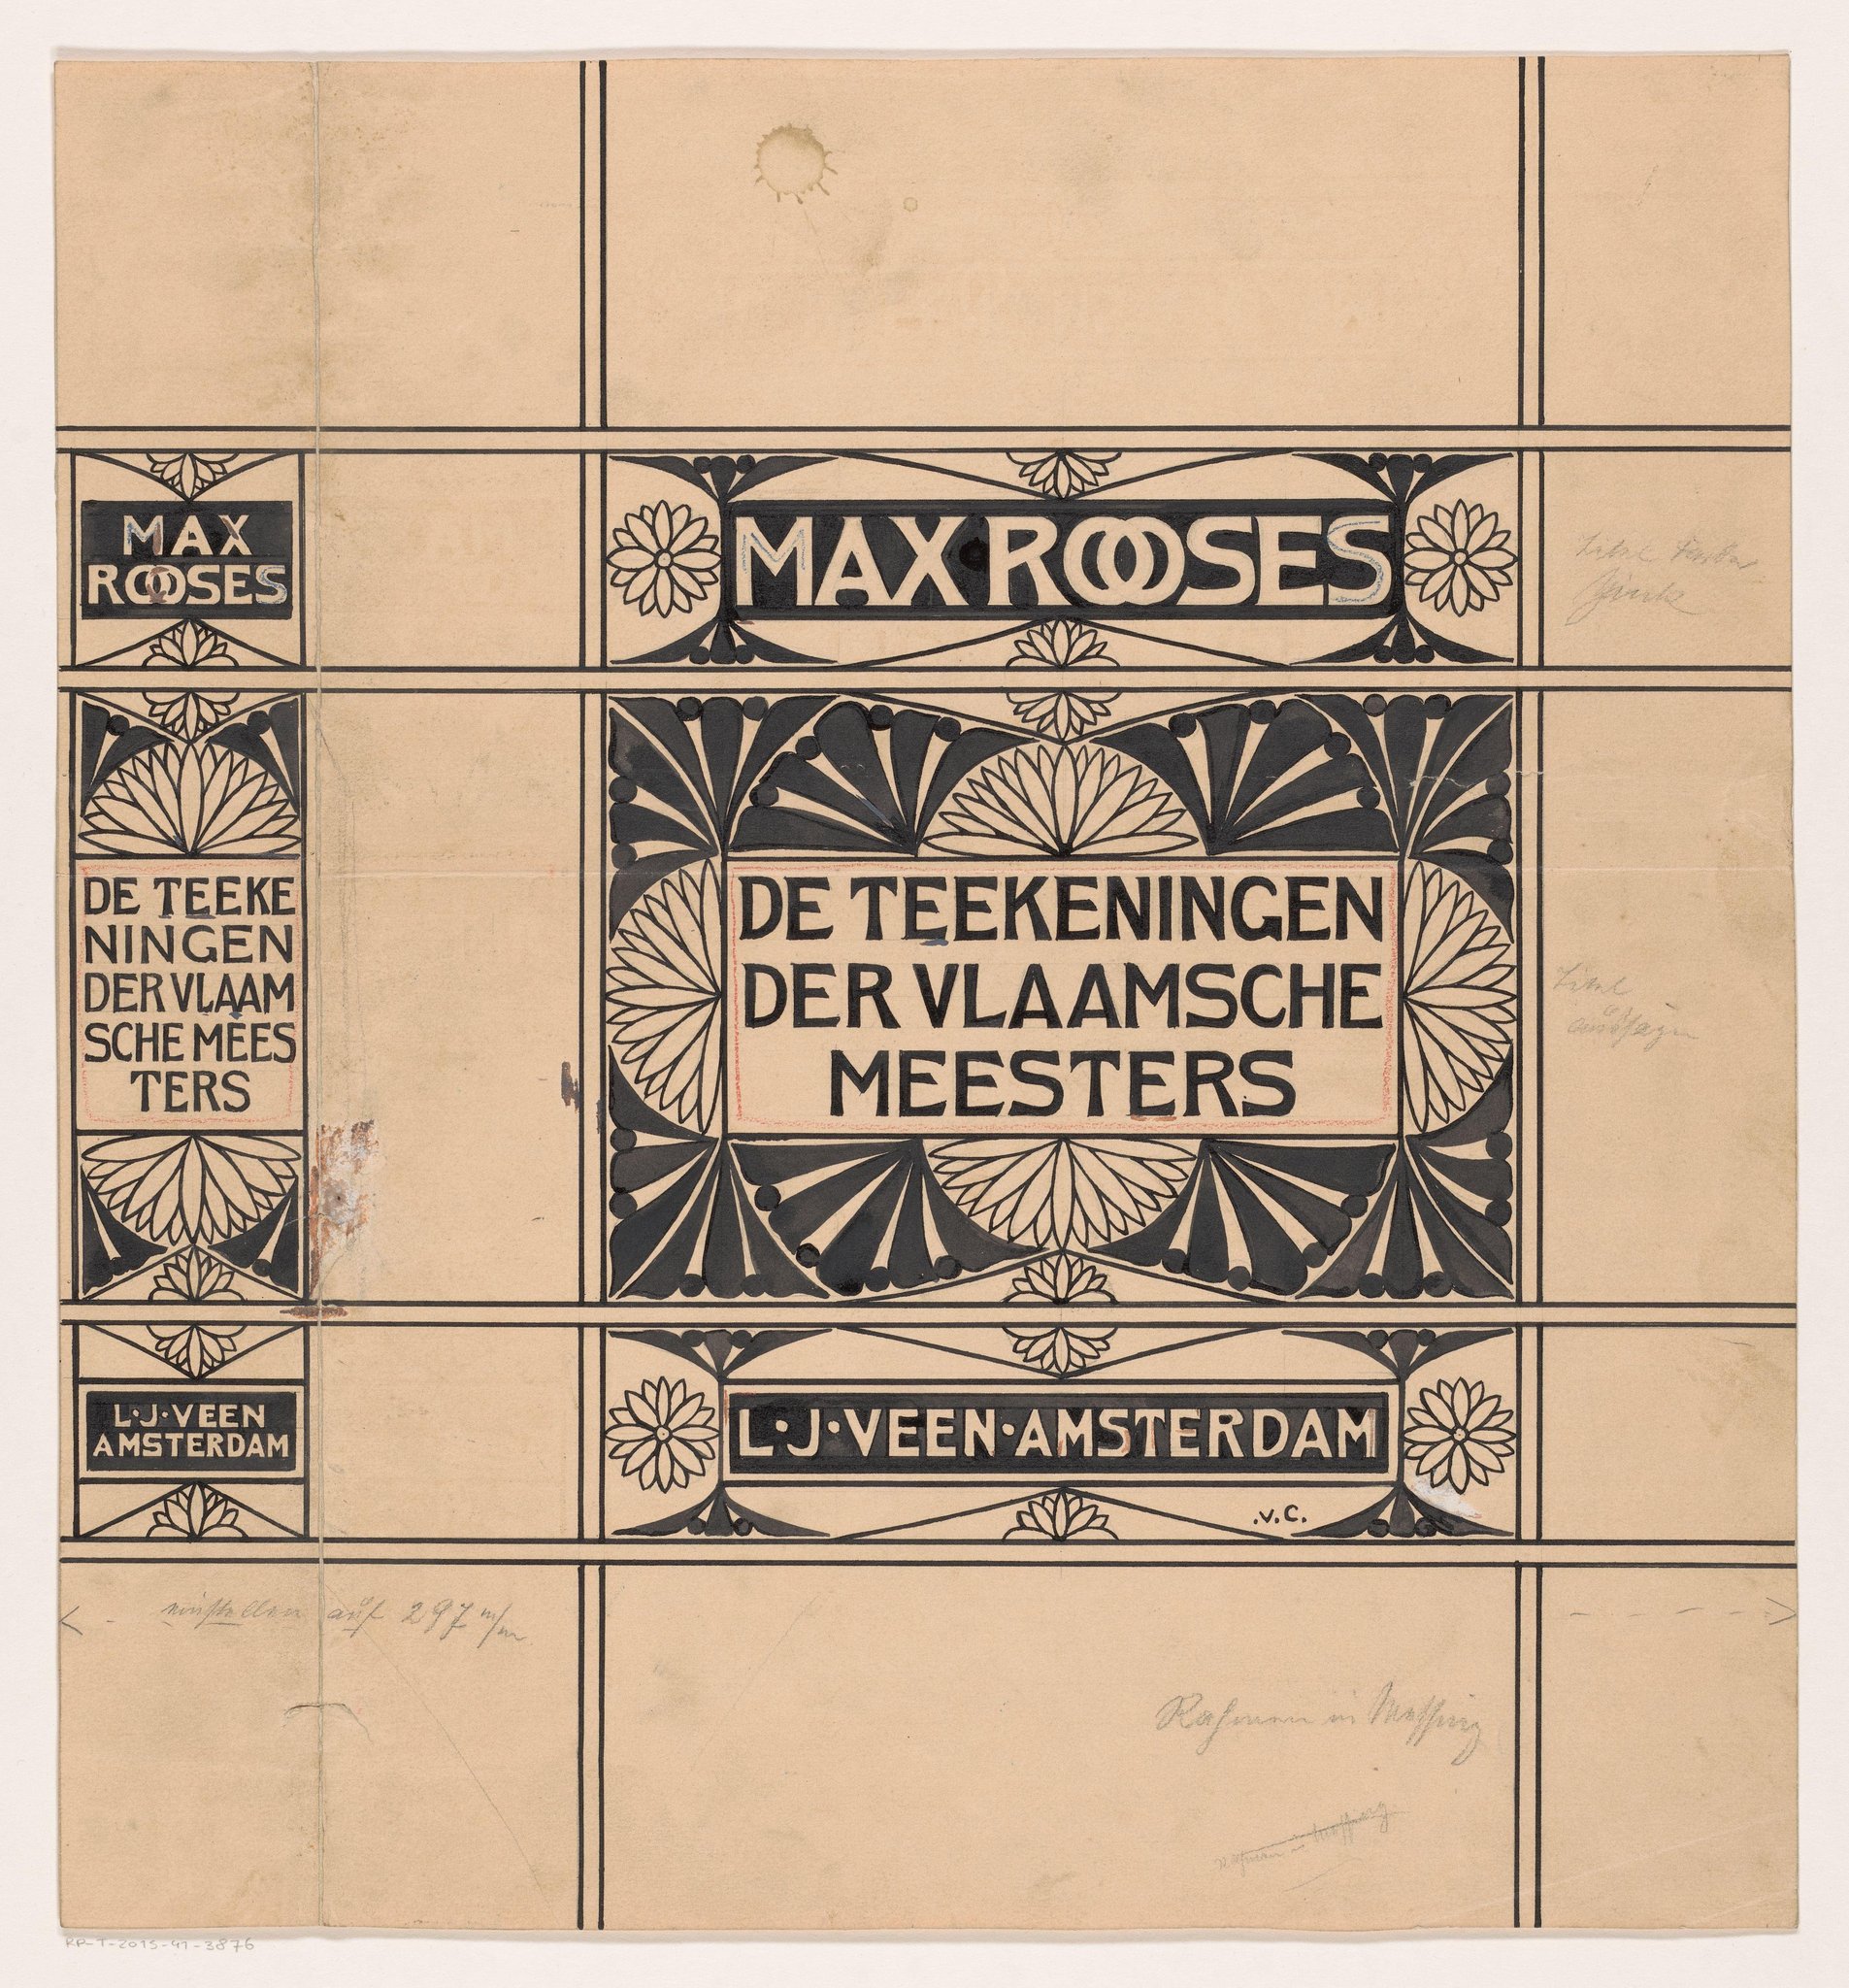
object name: study for binding design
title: Bandontwerp voor: Max Rooses, De teekeningen der Vlaamsche meesters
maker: johann georg van caspel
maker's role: draughtsman, print maker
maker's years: 1870-1928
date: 1900-1915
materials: chalk, paint, ink, paper, pencil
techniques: brush, pen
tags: flowers ~ ornament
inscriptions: annotation:, collector's mark: Lugt 2228a